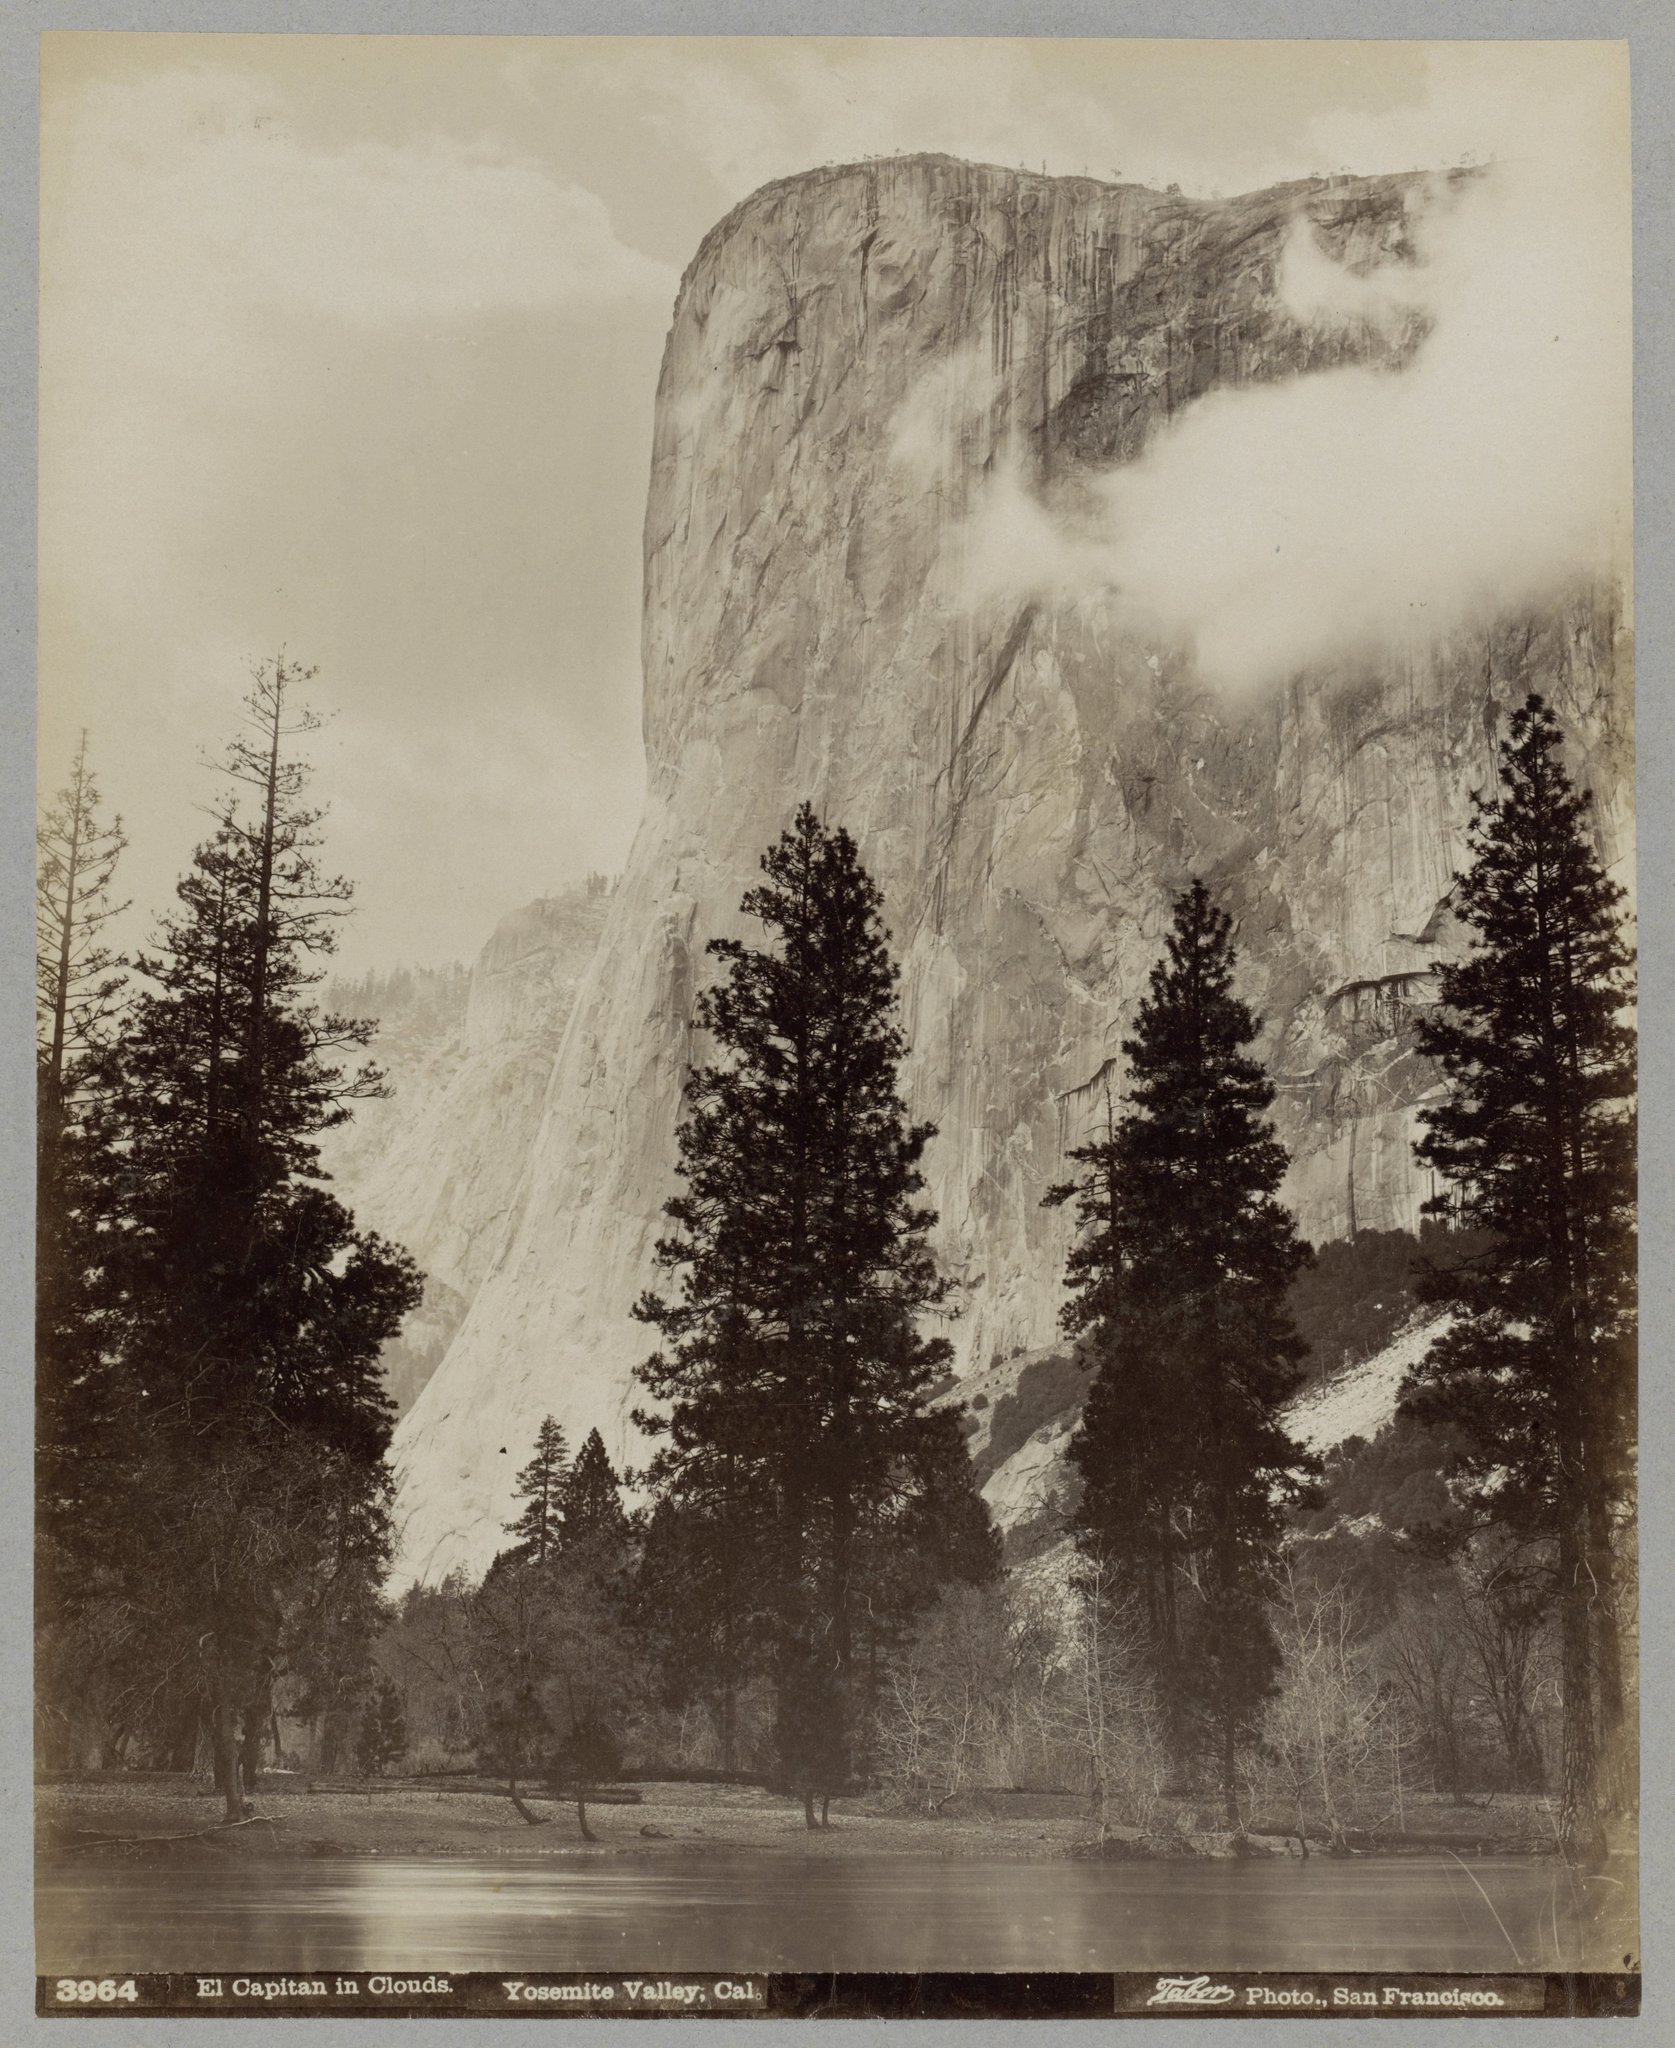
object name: photograph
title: El Capitan in Clouds. Yosemite Valley. Cal.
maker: isaiah west taber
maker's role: fotograaf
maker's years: 1830-1912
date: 1880-1900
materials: cardboard, paper, photographic support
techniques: albumen print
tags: rock-formations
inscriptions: negative number: ‘3964’